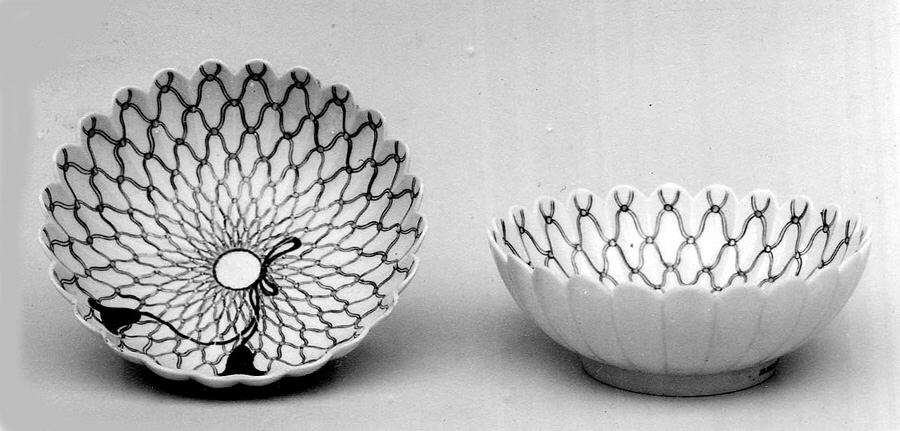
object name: bowl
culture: japanese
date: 1820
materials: enamel, porcelain